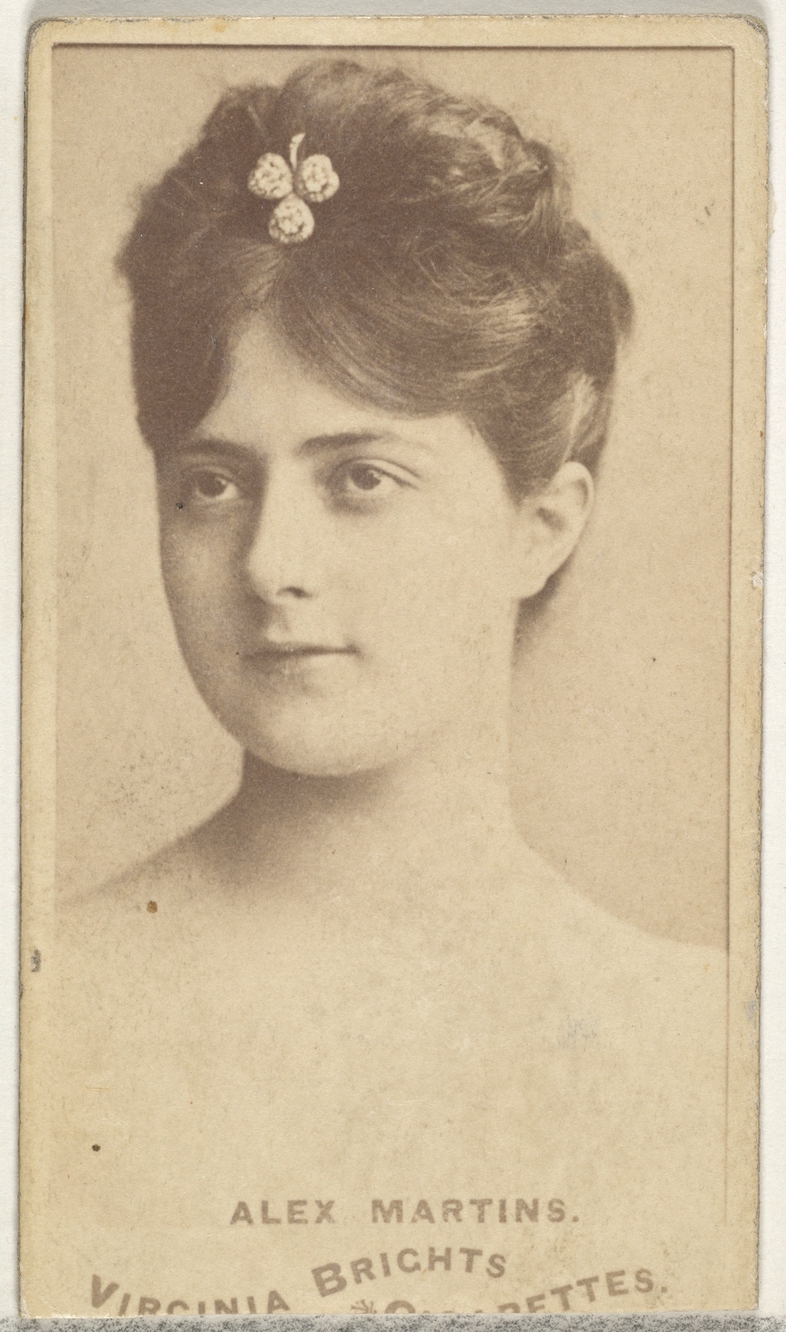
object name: photograph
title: Alex Martins, from the Actors and Actresses series (N45, Type 1) for Virginia Brights Cigarettes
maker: allen & ginter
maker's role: publisher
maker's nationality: american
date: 1888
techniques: albumen silver print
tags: portraits,women,actresses